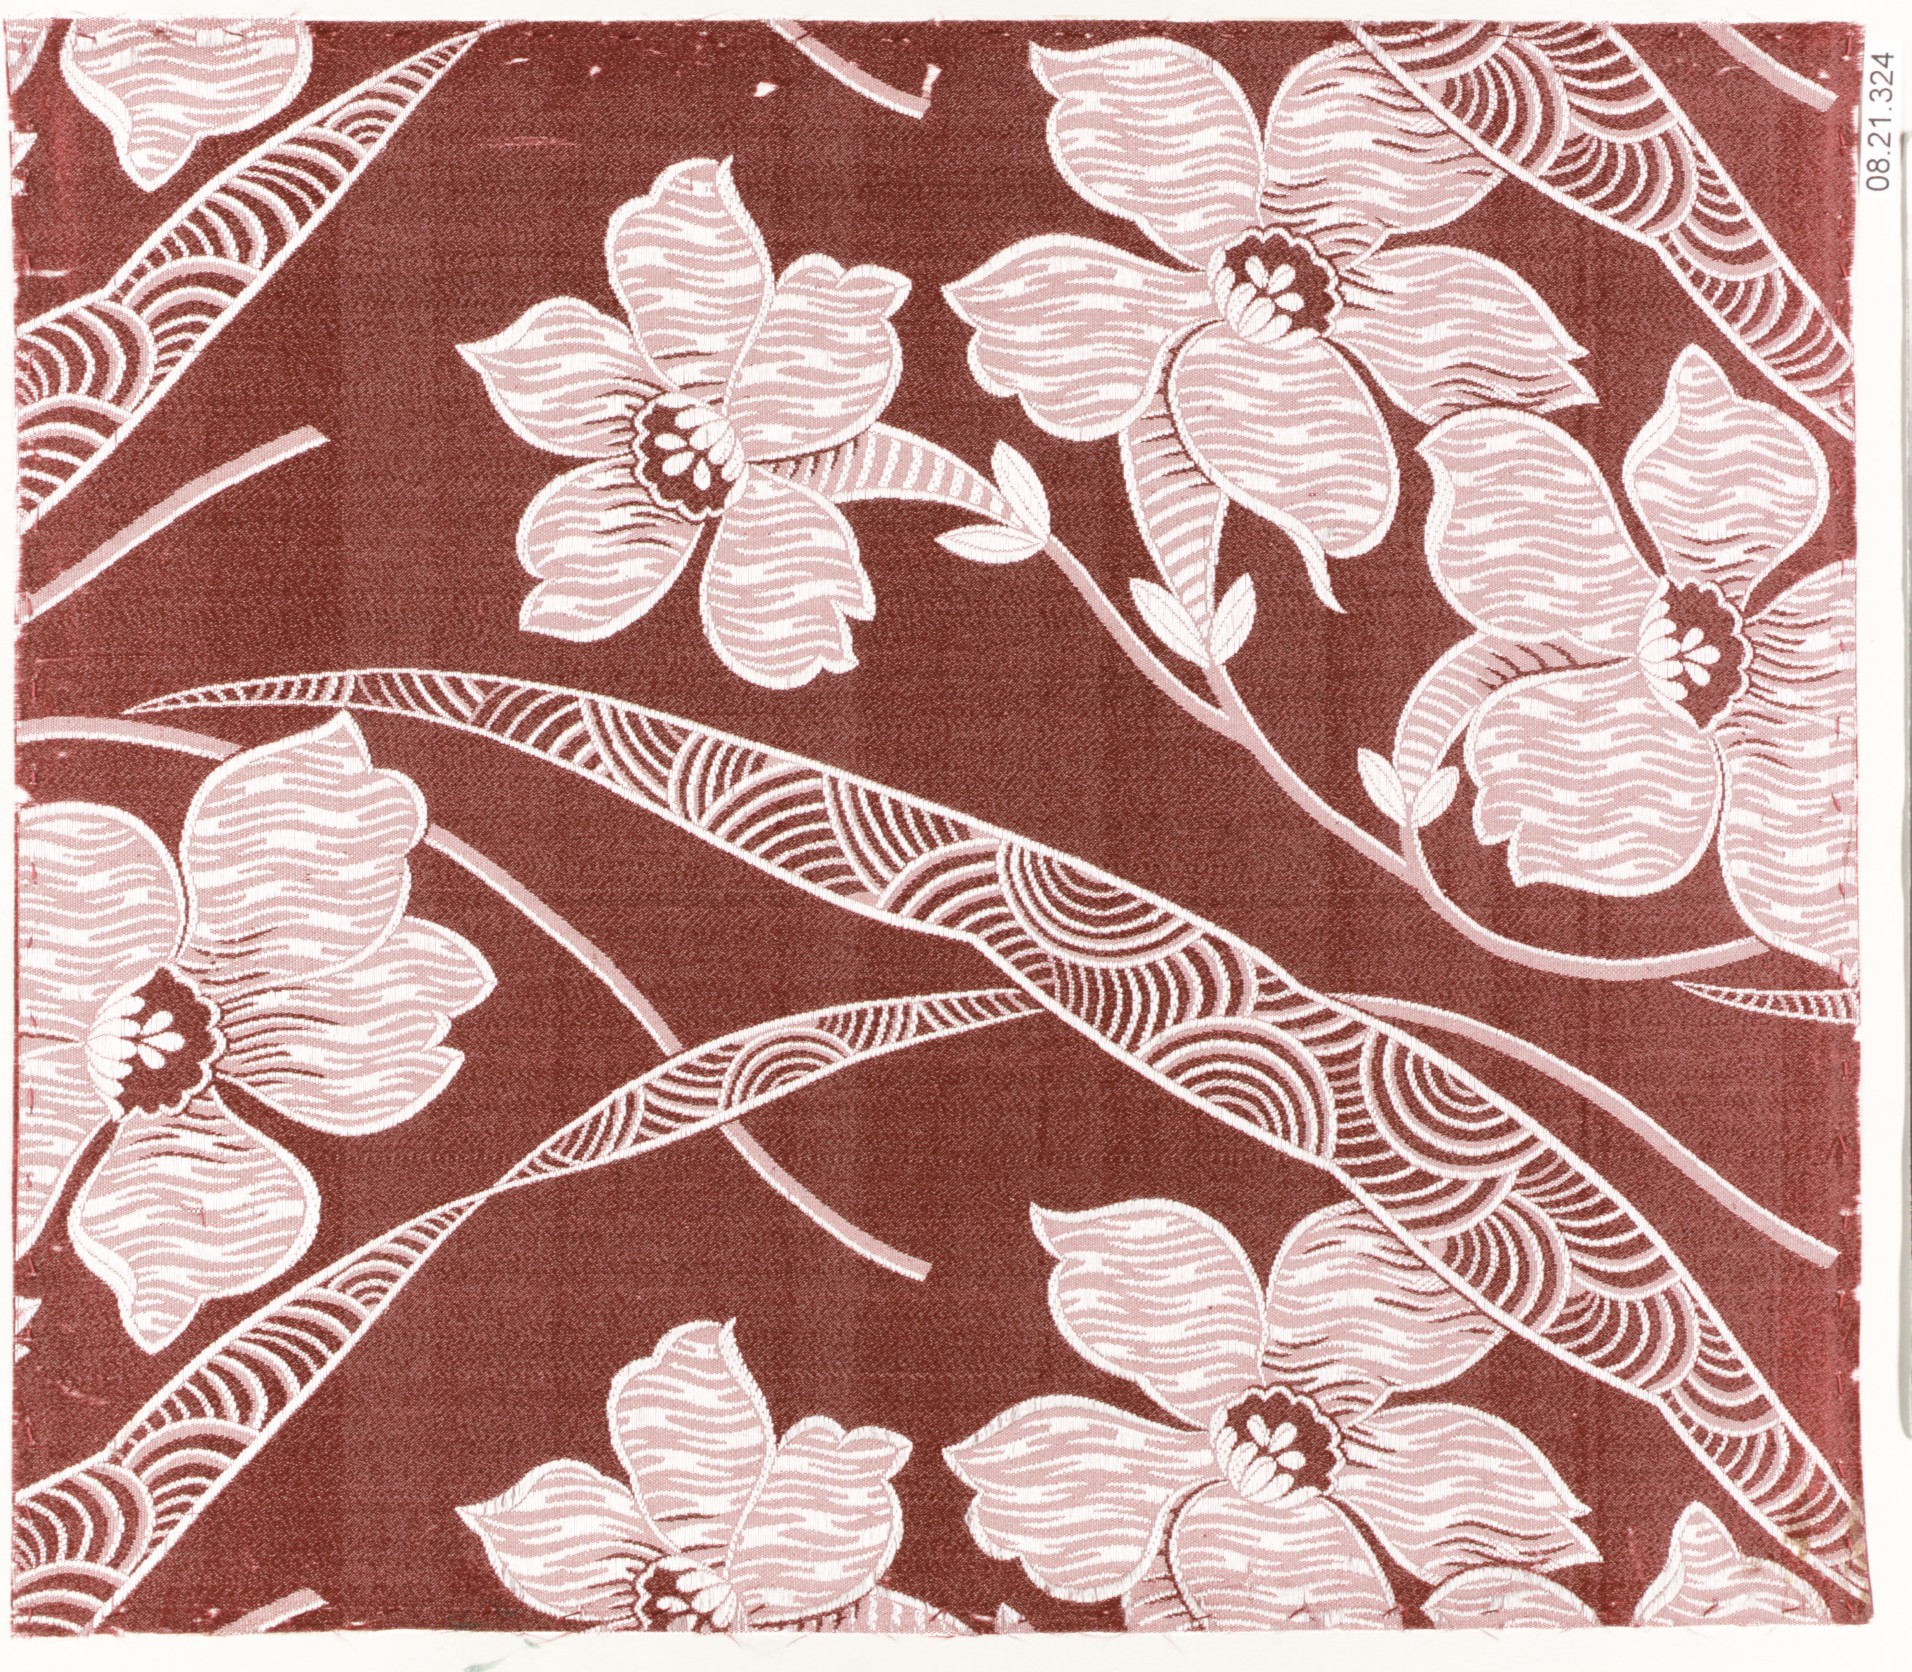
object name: textile sample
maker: Anonymous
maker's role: designer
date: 1900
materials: silk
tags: flowers